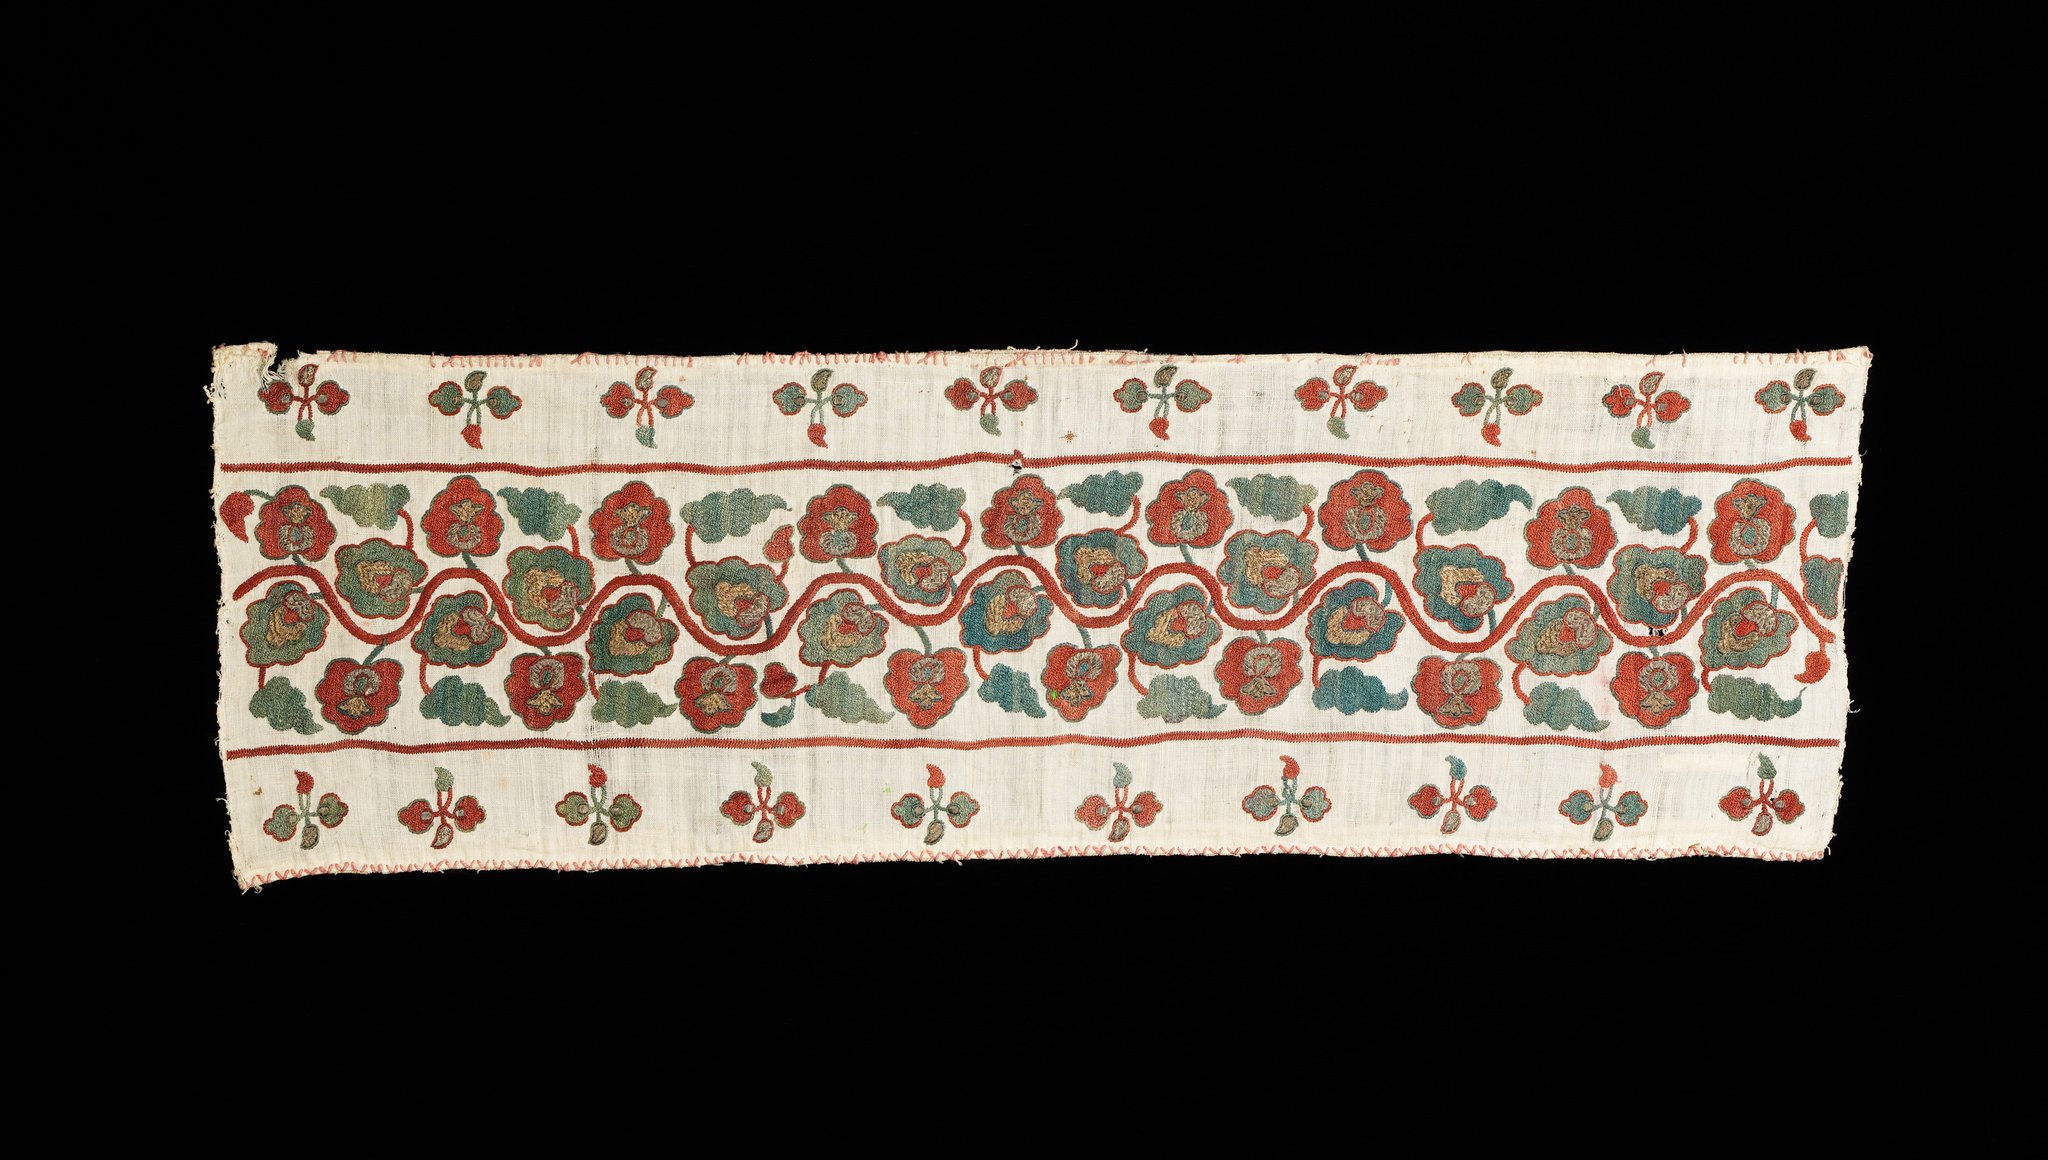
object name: textile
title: Fragment of a shirt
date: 1776-1800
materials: linen, metal, silk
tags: leaves